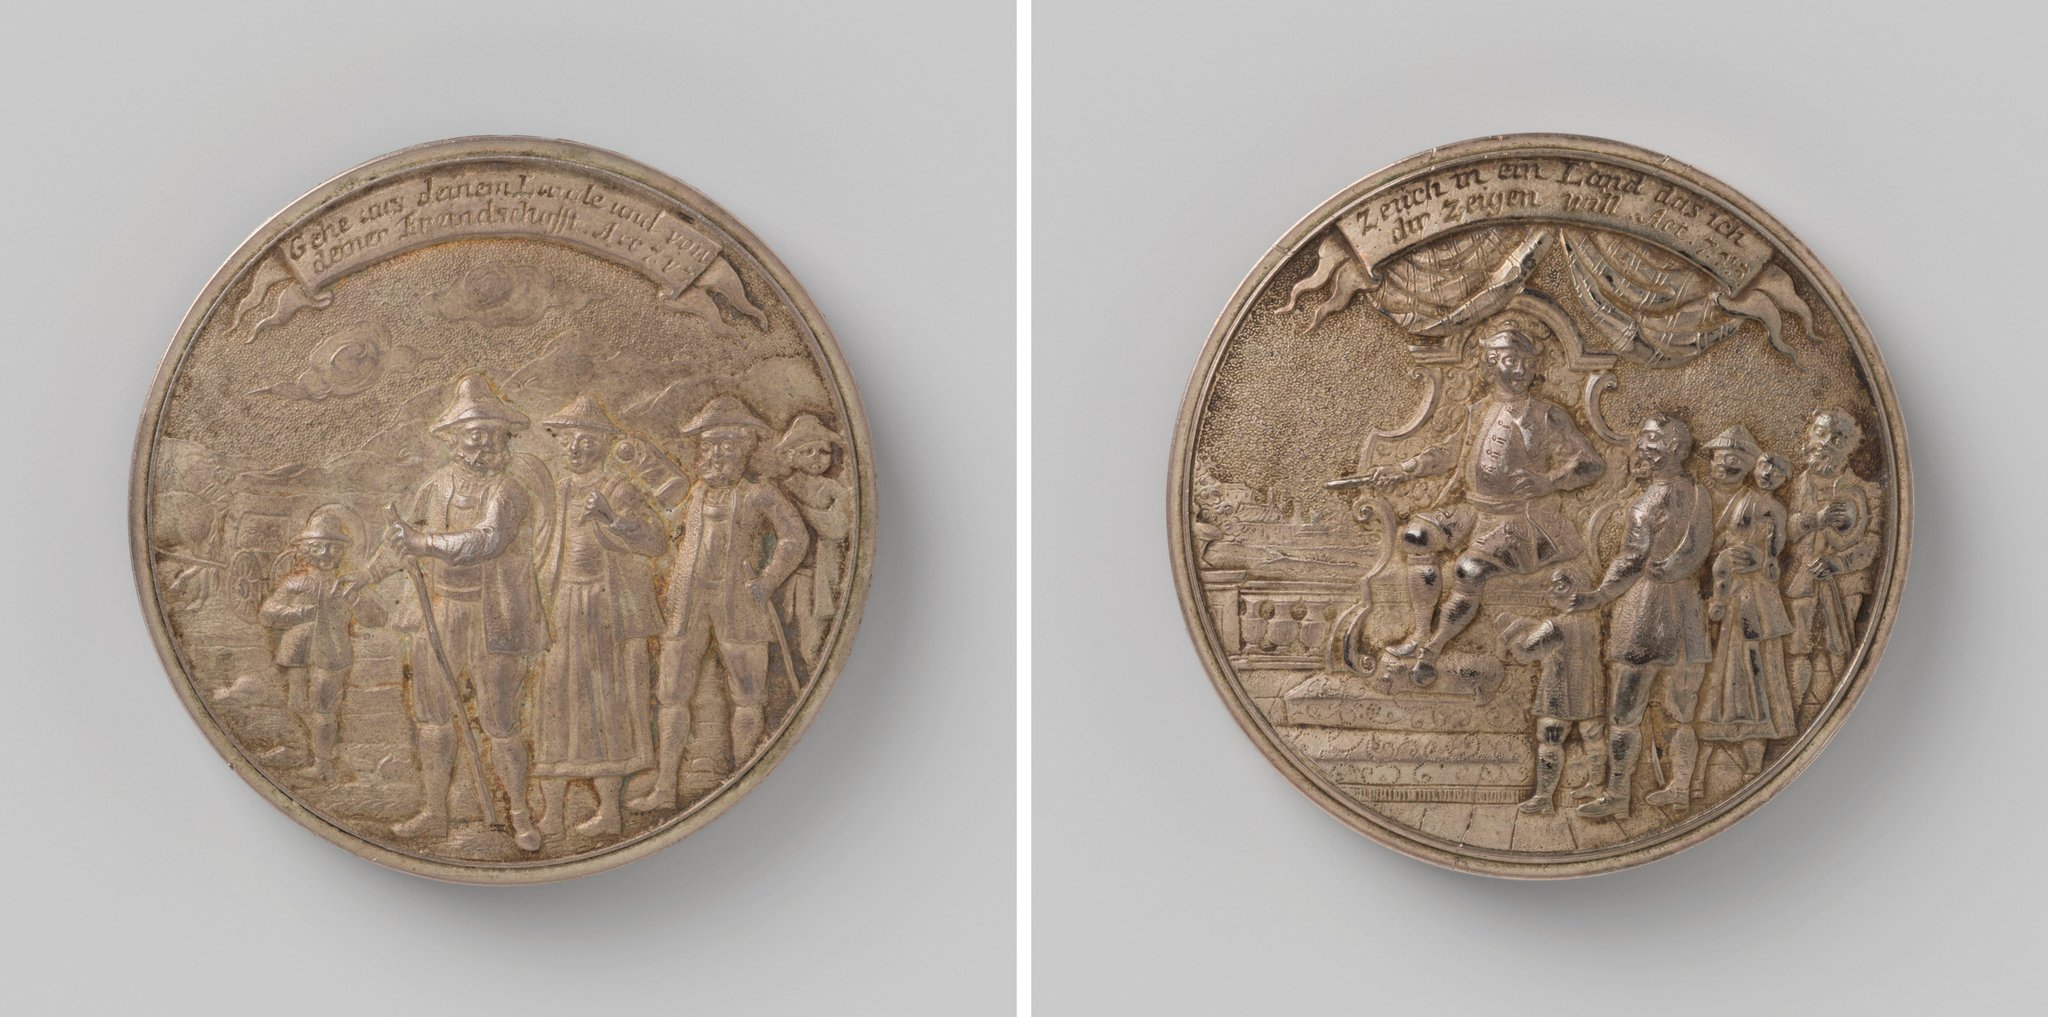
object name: box taler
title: Opname der Salzburger emigranten in Pruisen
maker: daniel hoeckhinger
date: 1732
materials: paper, silver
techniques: printing, striking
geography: augsburg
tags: salzburg, pruisen, opname der salzburger emigranten in pruisen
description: Schroefpenning gevormd door de gedenkpenning op de uitdrijving der Tiroolse Hervormden. Inwendig een kaart van Pruisen en een van Tirol door Daniel Hockhinger. Verder zeventien losse, ronde prenten.